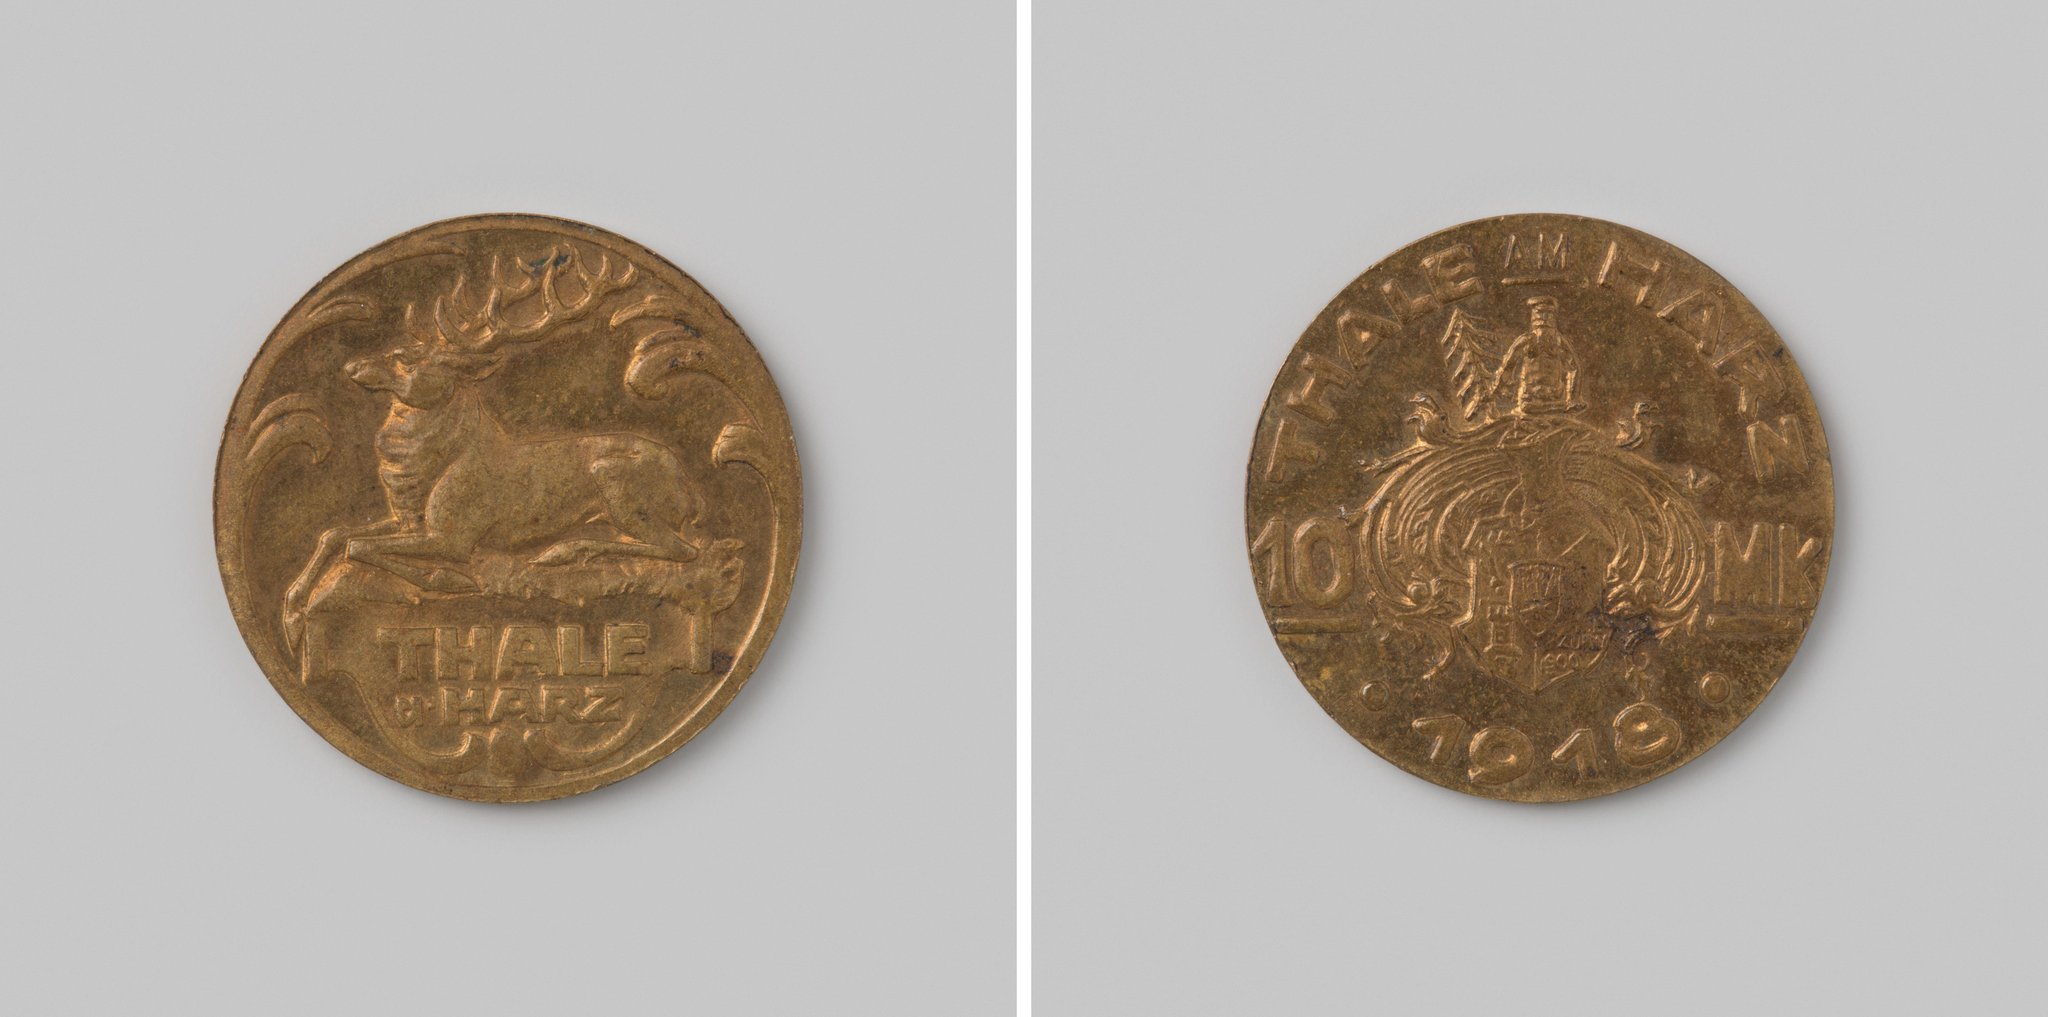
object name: coin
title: Tien mark uit Duitsland, noodmunt van Thale am Harz, 1918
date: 1918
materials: brass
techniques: striking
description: Messing noodmunt. Voorzijde: binnen versiering sprigend hert naar links. Daaronder in twee regels plaats-aanduiding. Keerzijde: tussen waarde-aanduiding wapenschild van de stad met helmteken, waaronder jaartal in het omschrift. Gladde rand.